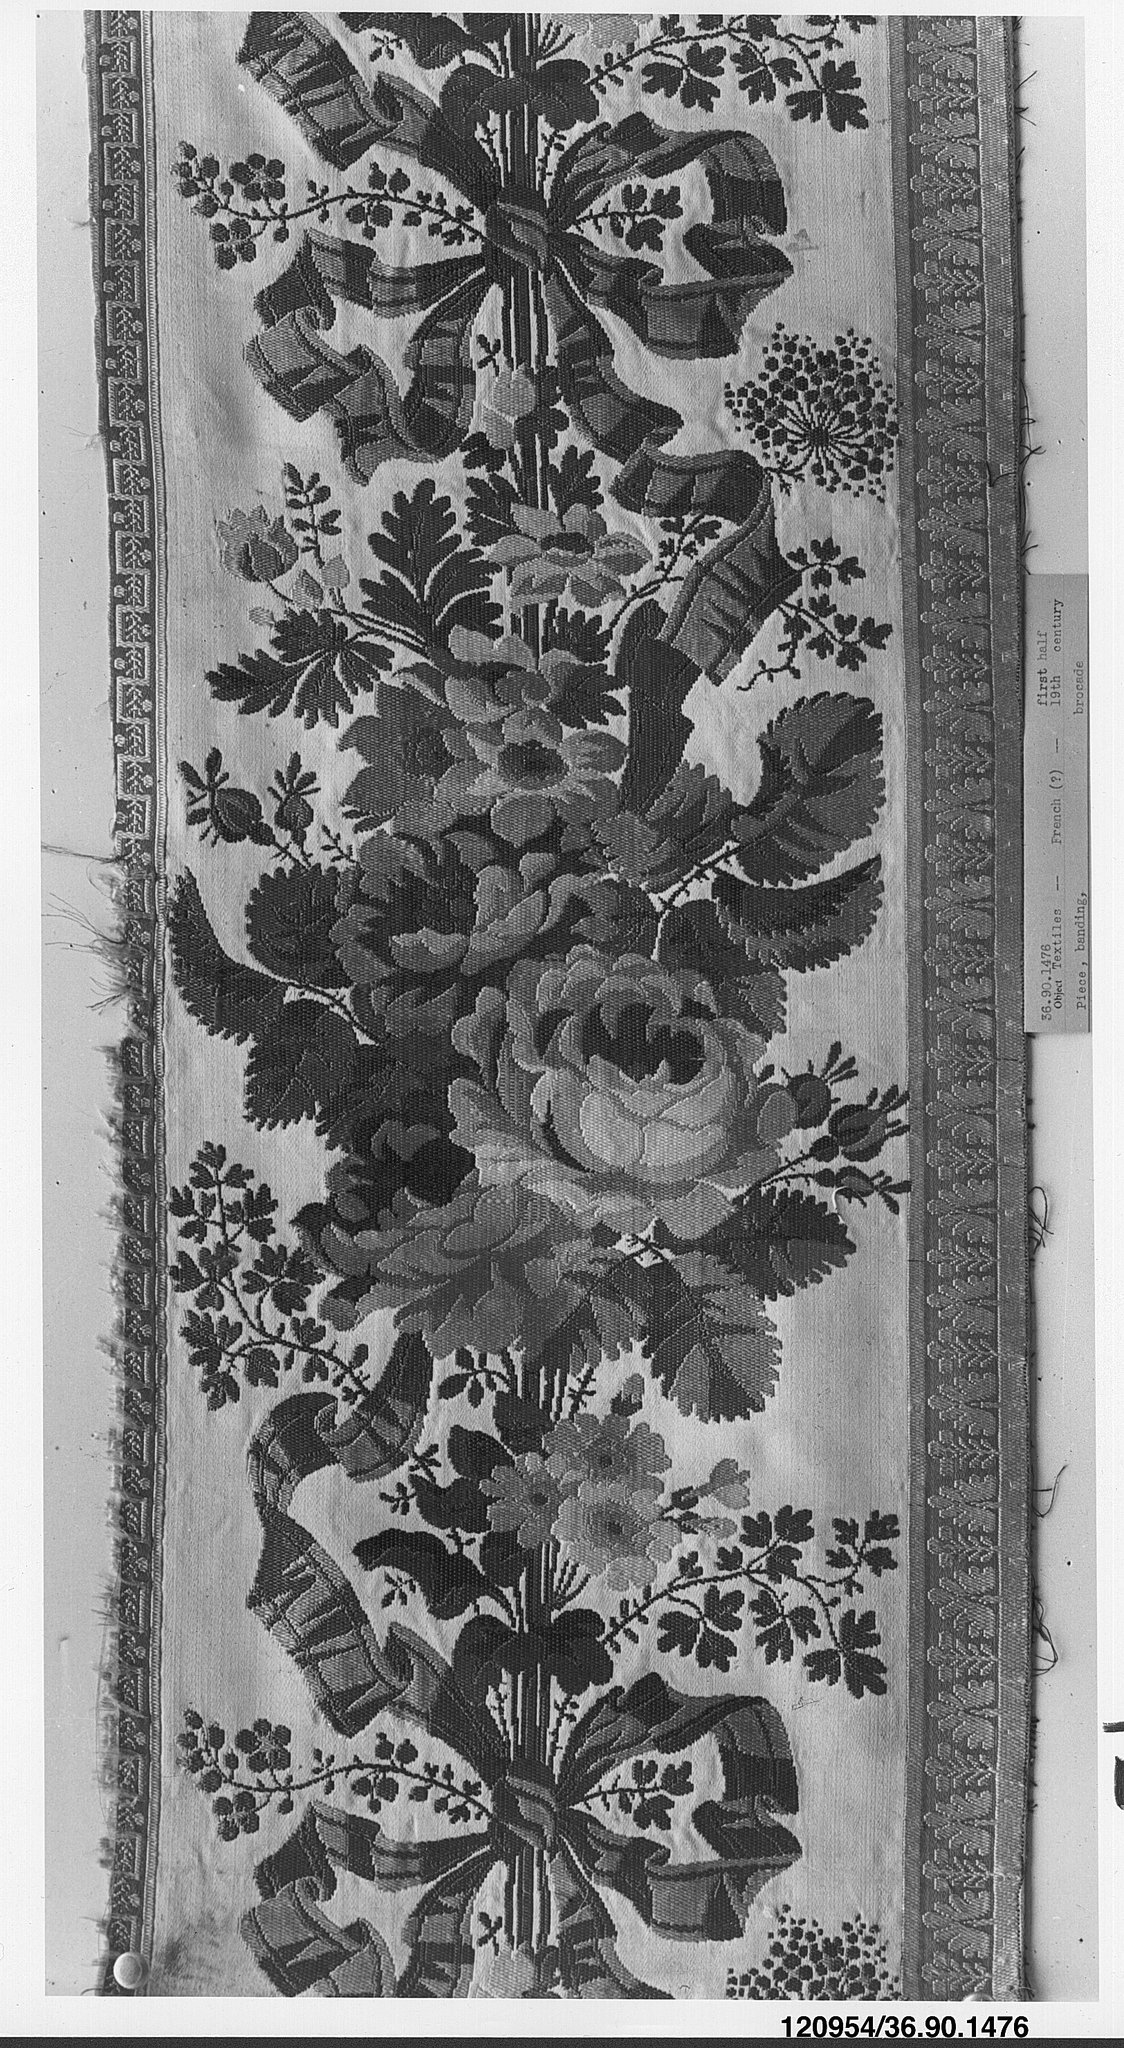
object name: band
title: Banding piece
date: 1801-1900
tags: flowers,roses,leaves